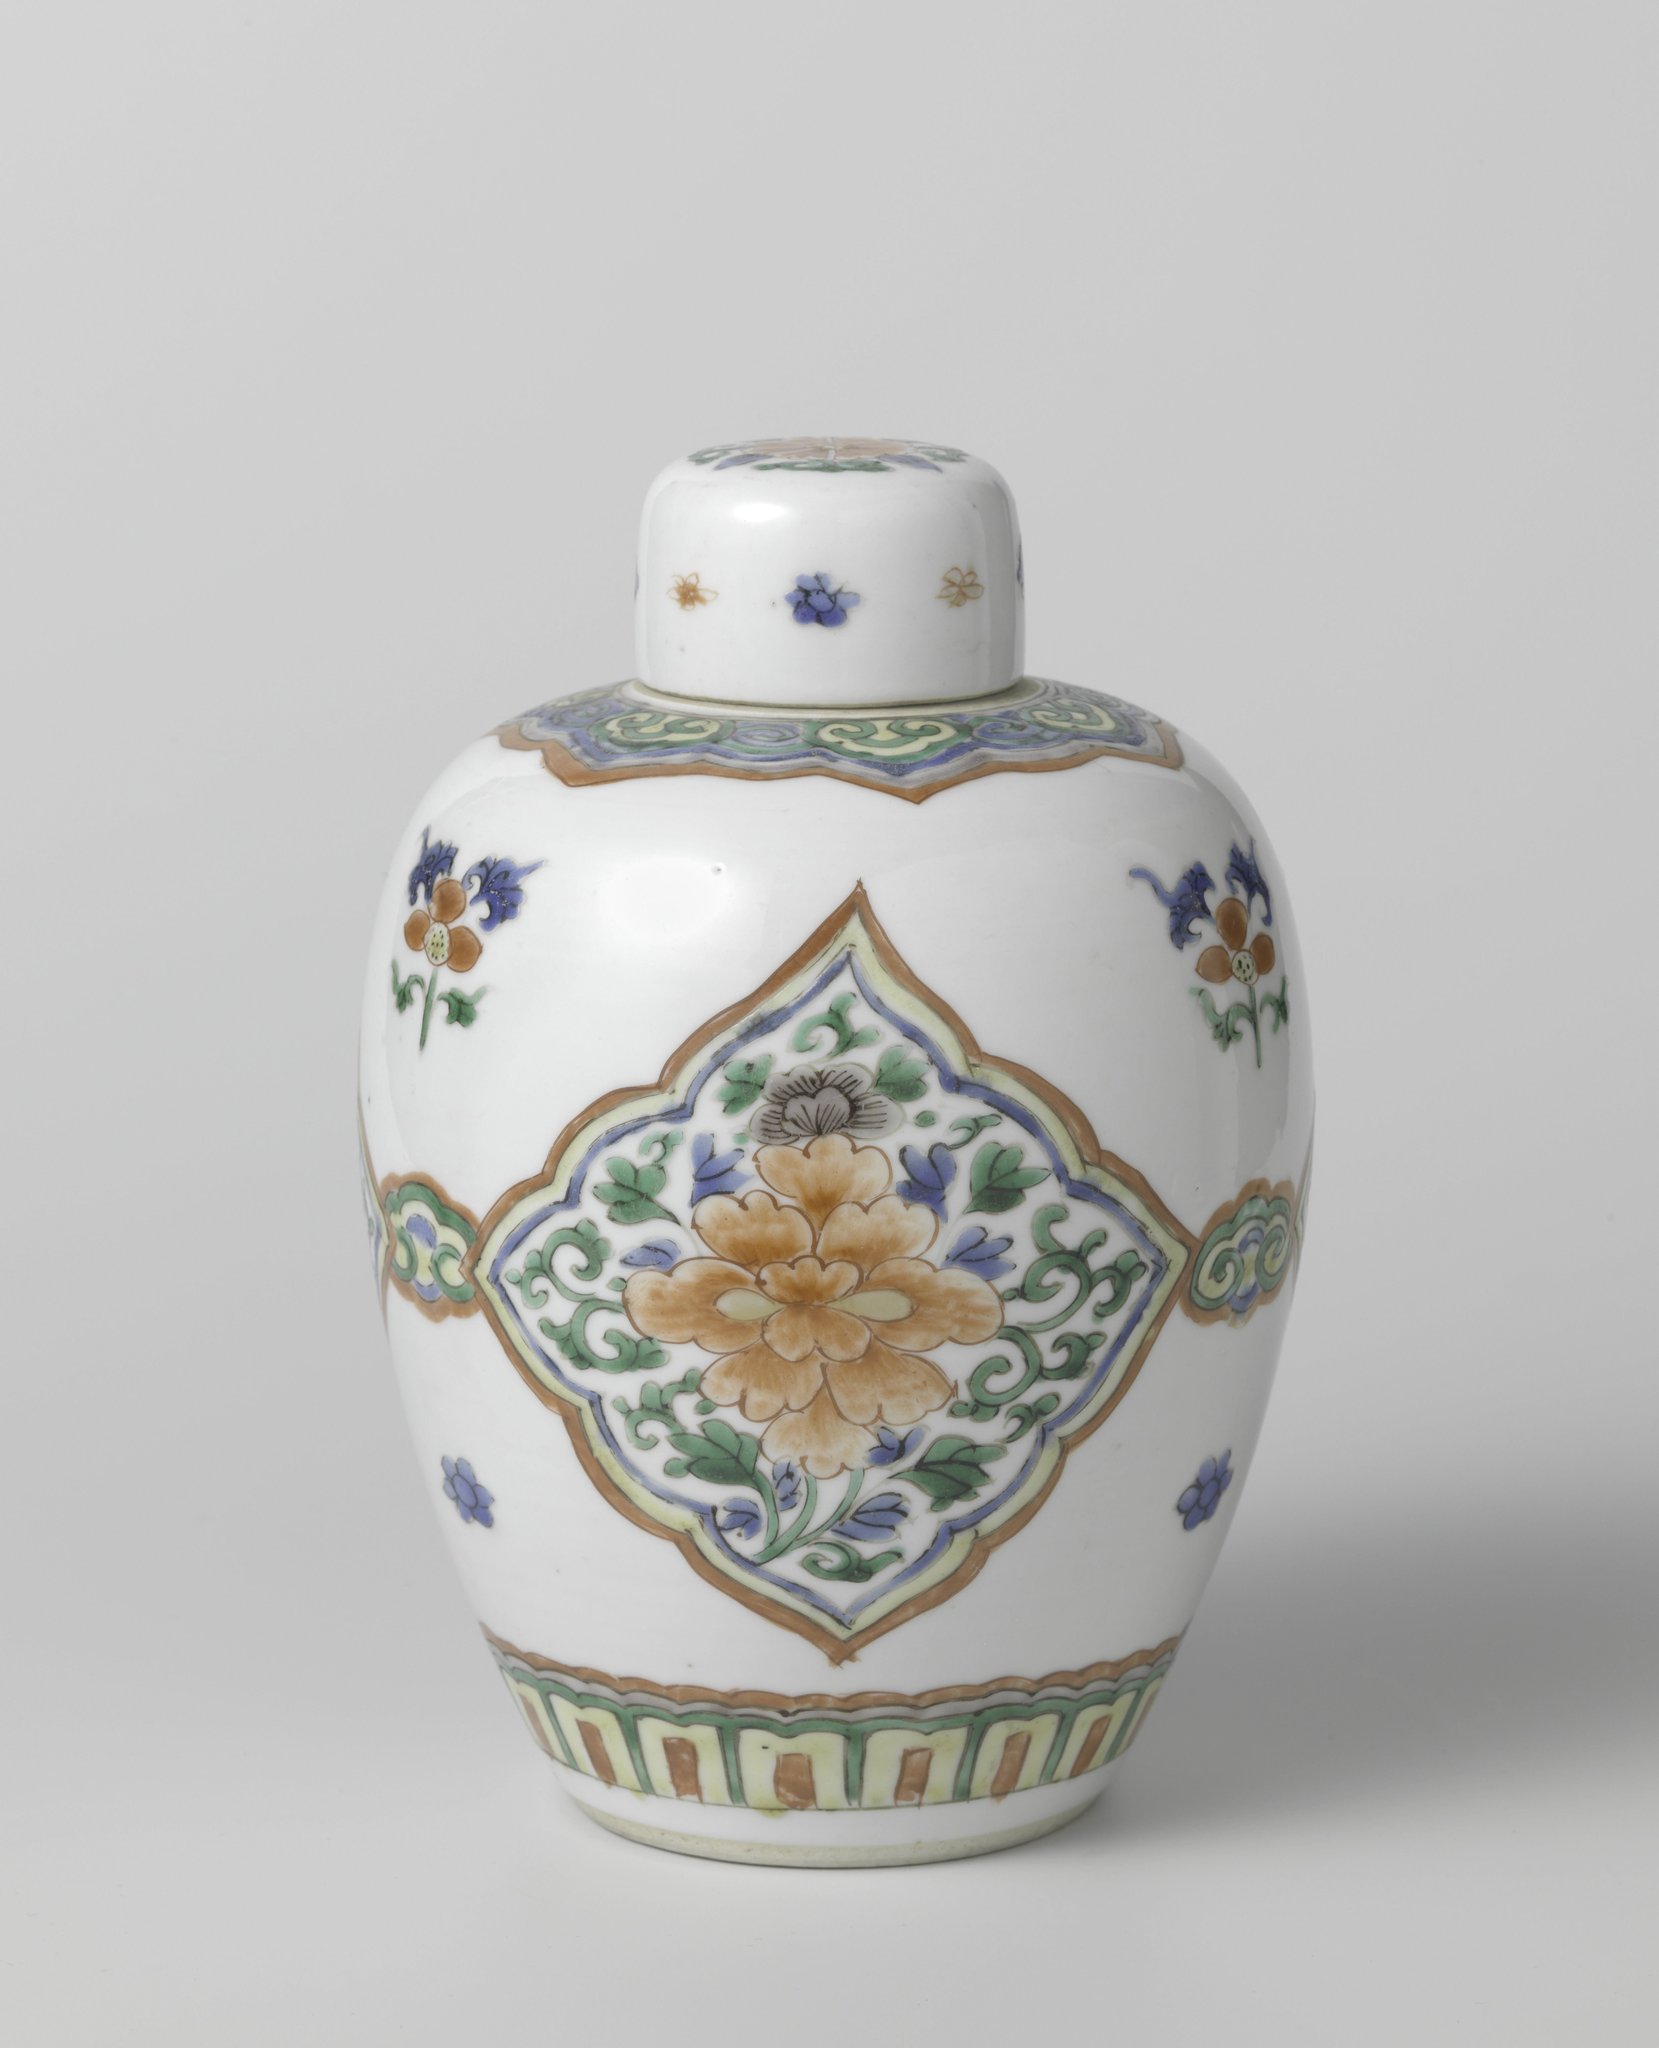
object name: pot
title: Covered jar with ruyi-heads and flowers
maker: Anonymous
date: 1700-1724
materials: glaze, paint, porcelain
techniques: firing, turning, vitrification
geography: china